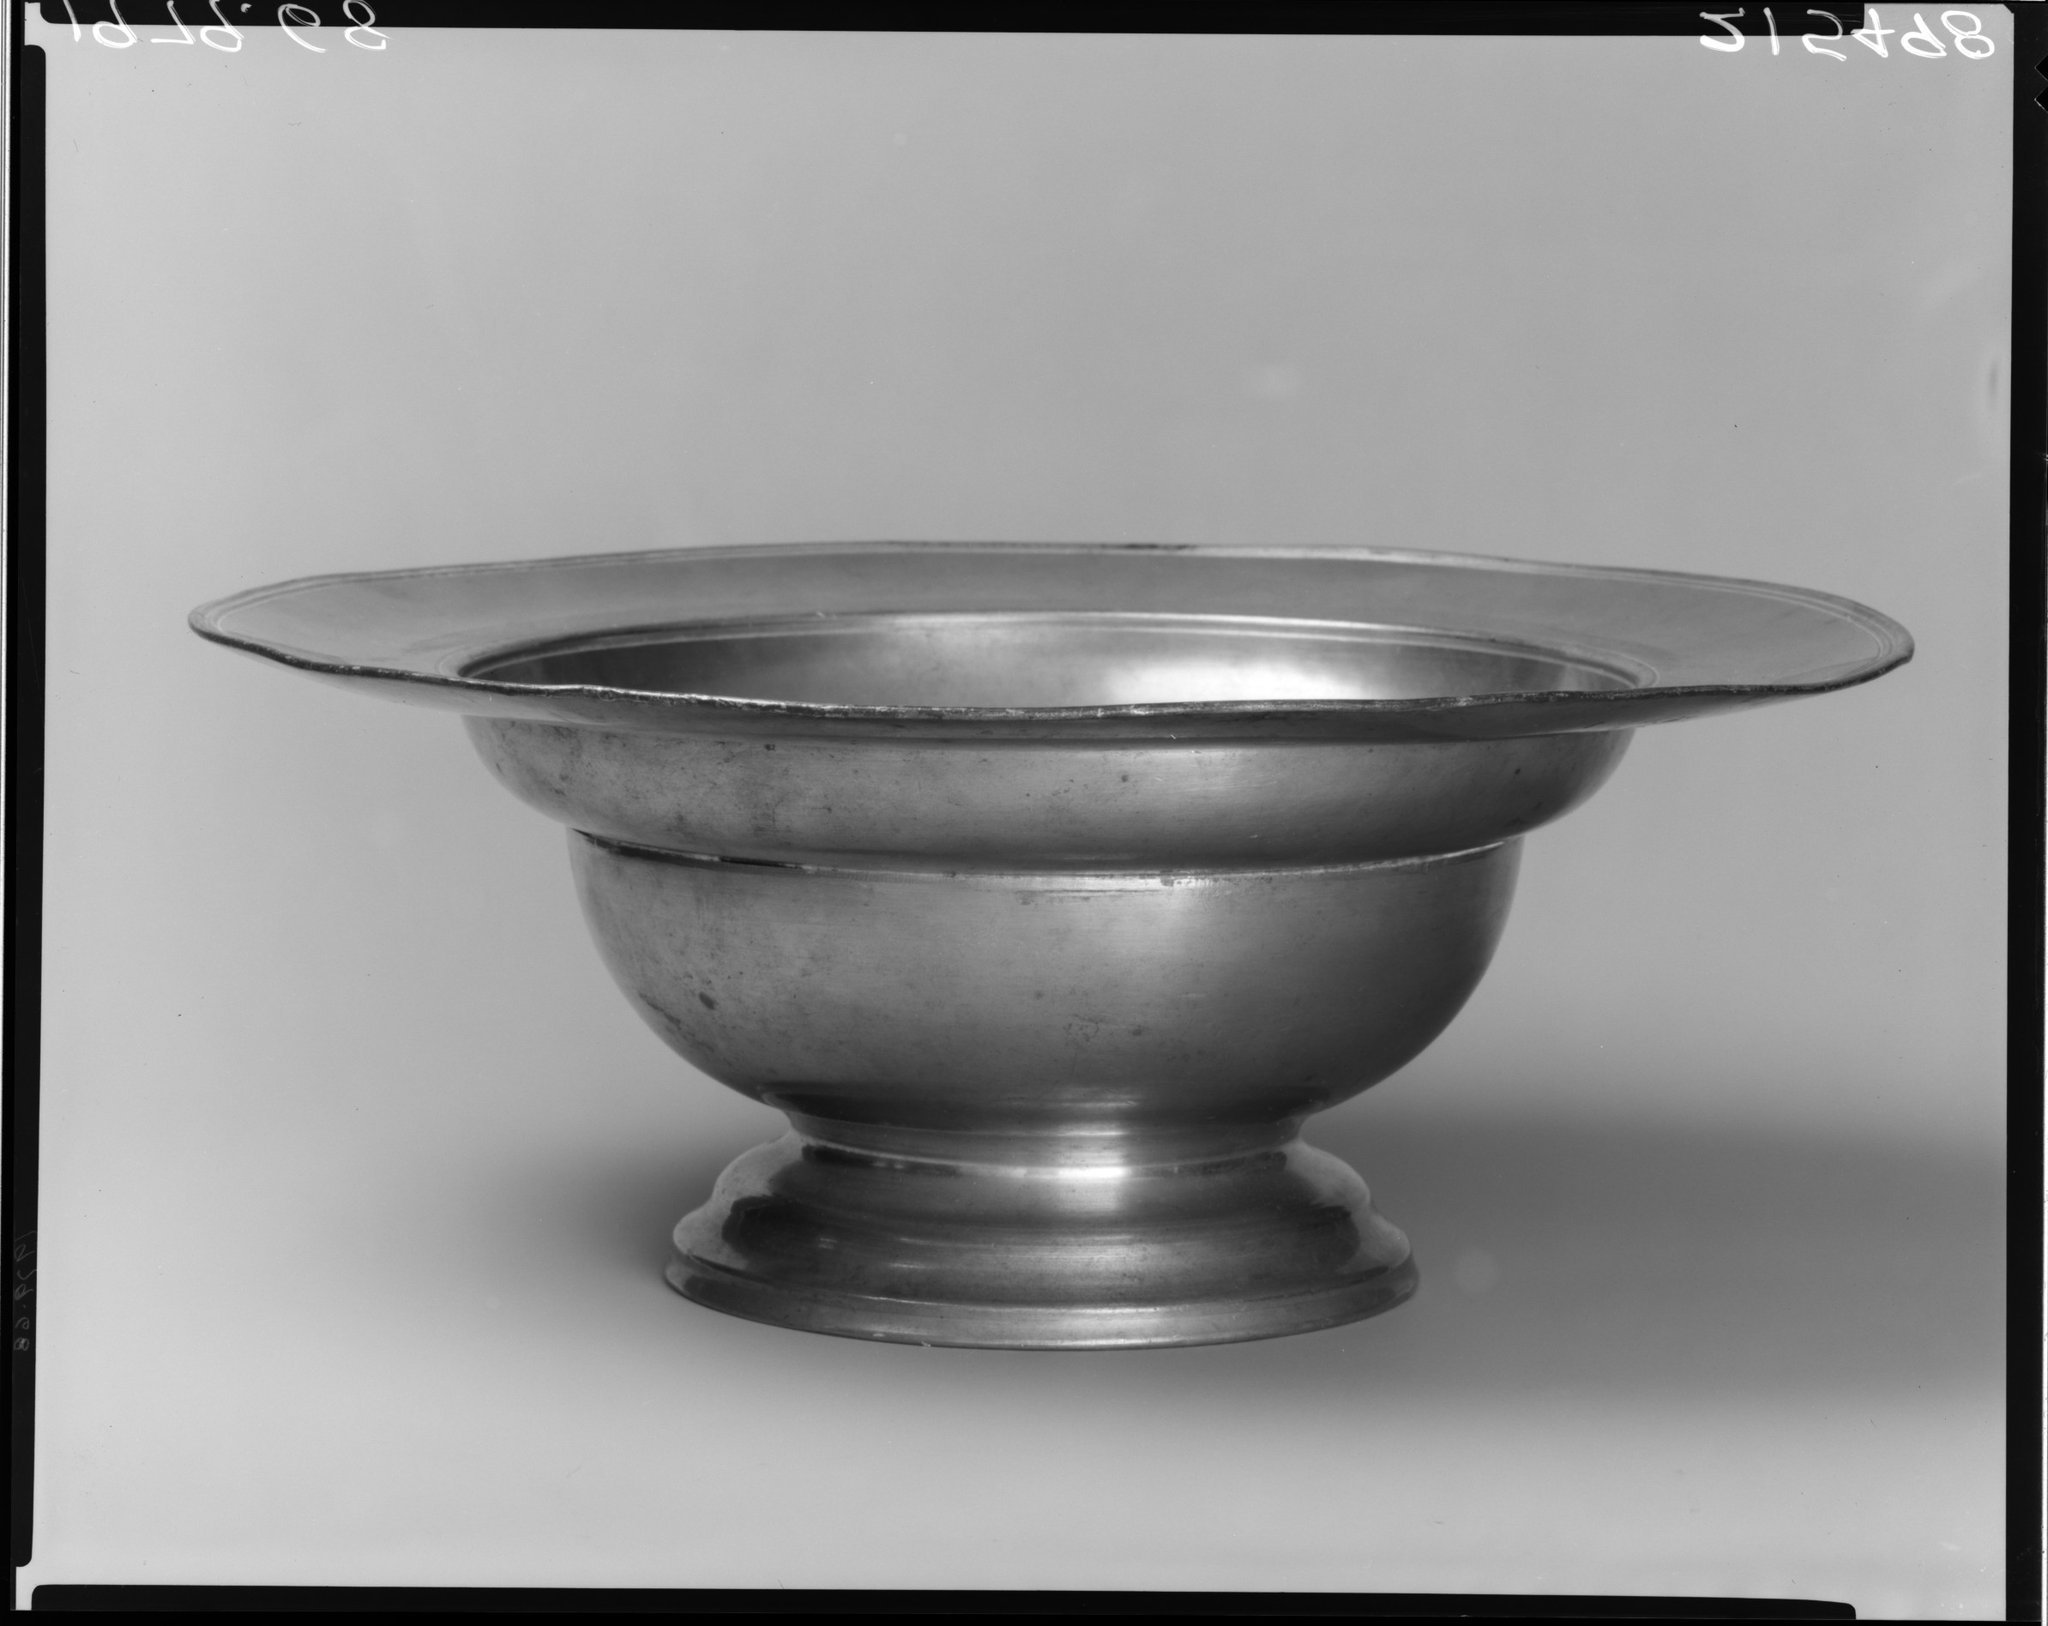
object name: baptismal bowl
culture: american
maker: oliver trask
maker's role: maker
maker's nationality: american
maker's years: 1792-1847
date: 1830-1840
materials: pewter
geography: united states